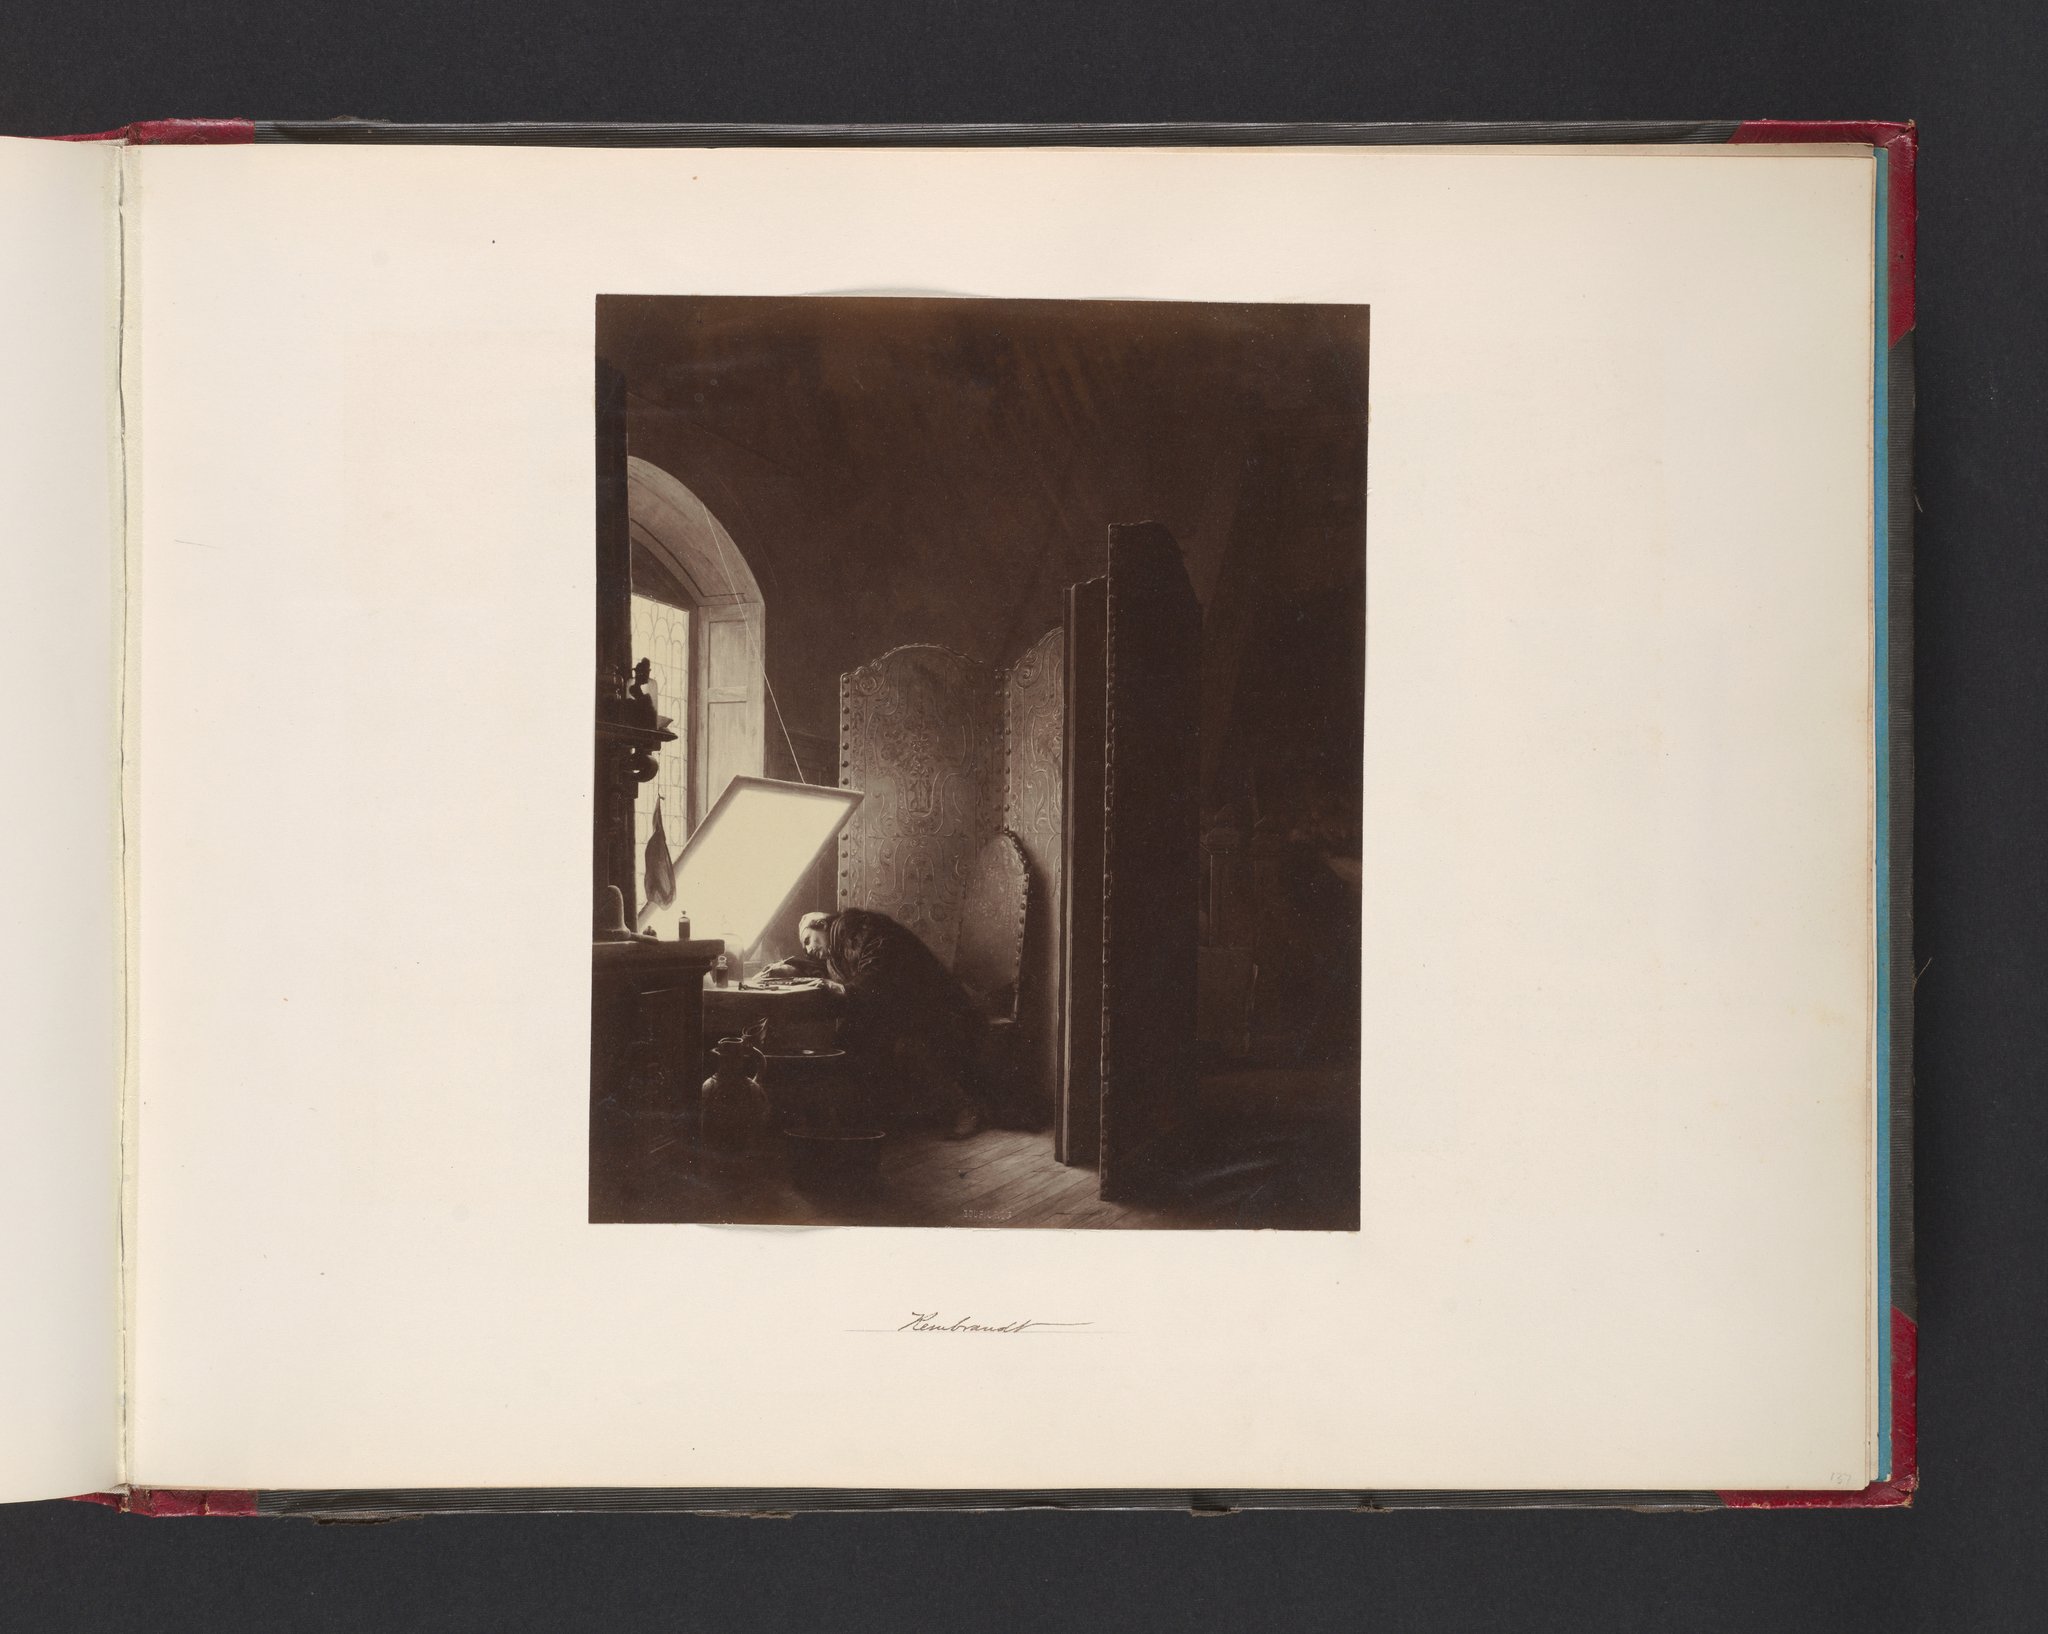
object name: photograph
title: Rembrandt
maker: john thomson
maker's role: artist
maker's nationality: british, scottish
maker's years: 1837-1921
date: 1865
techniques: albumen silver print, glass negative